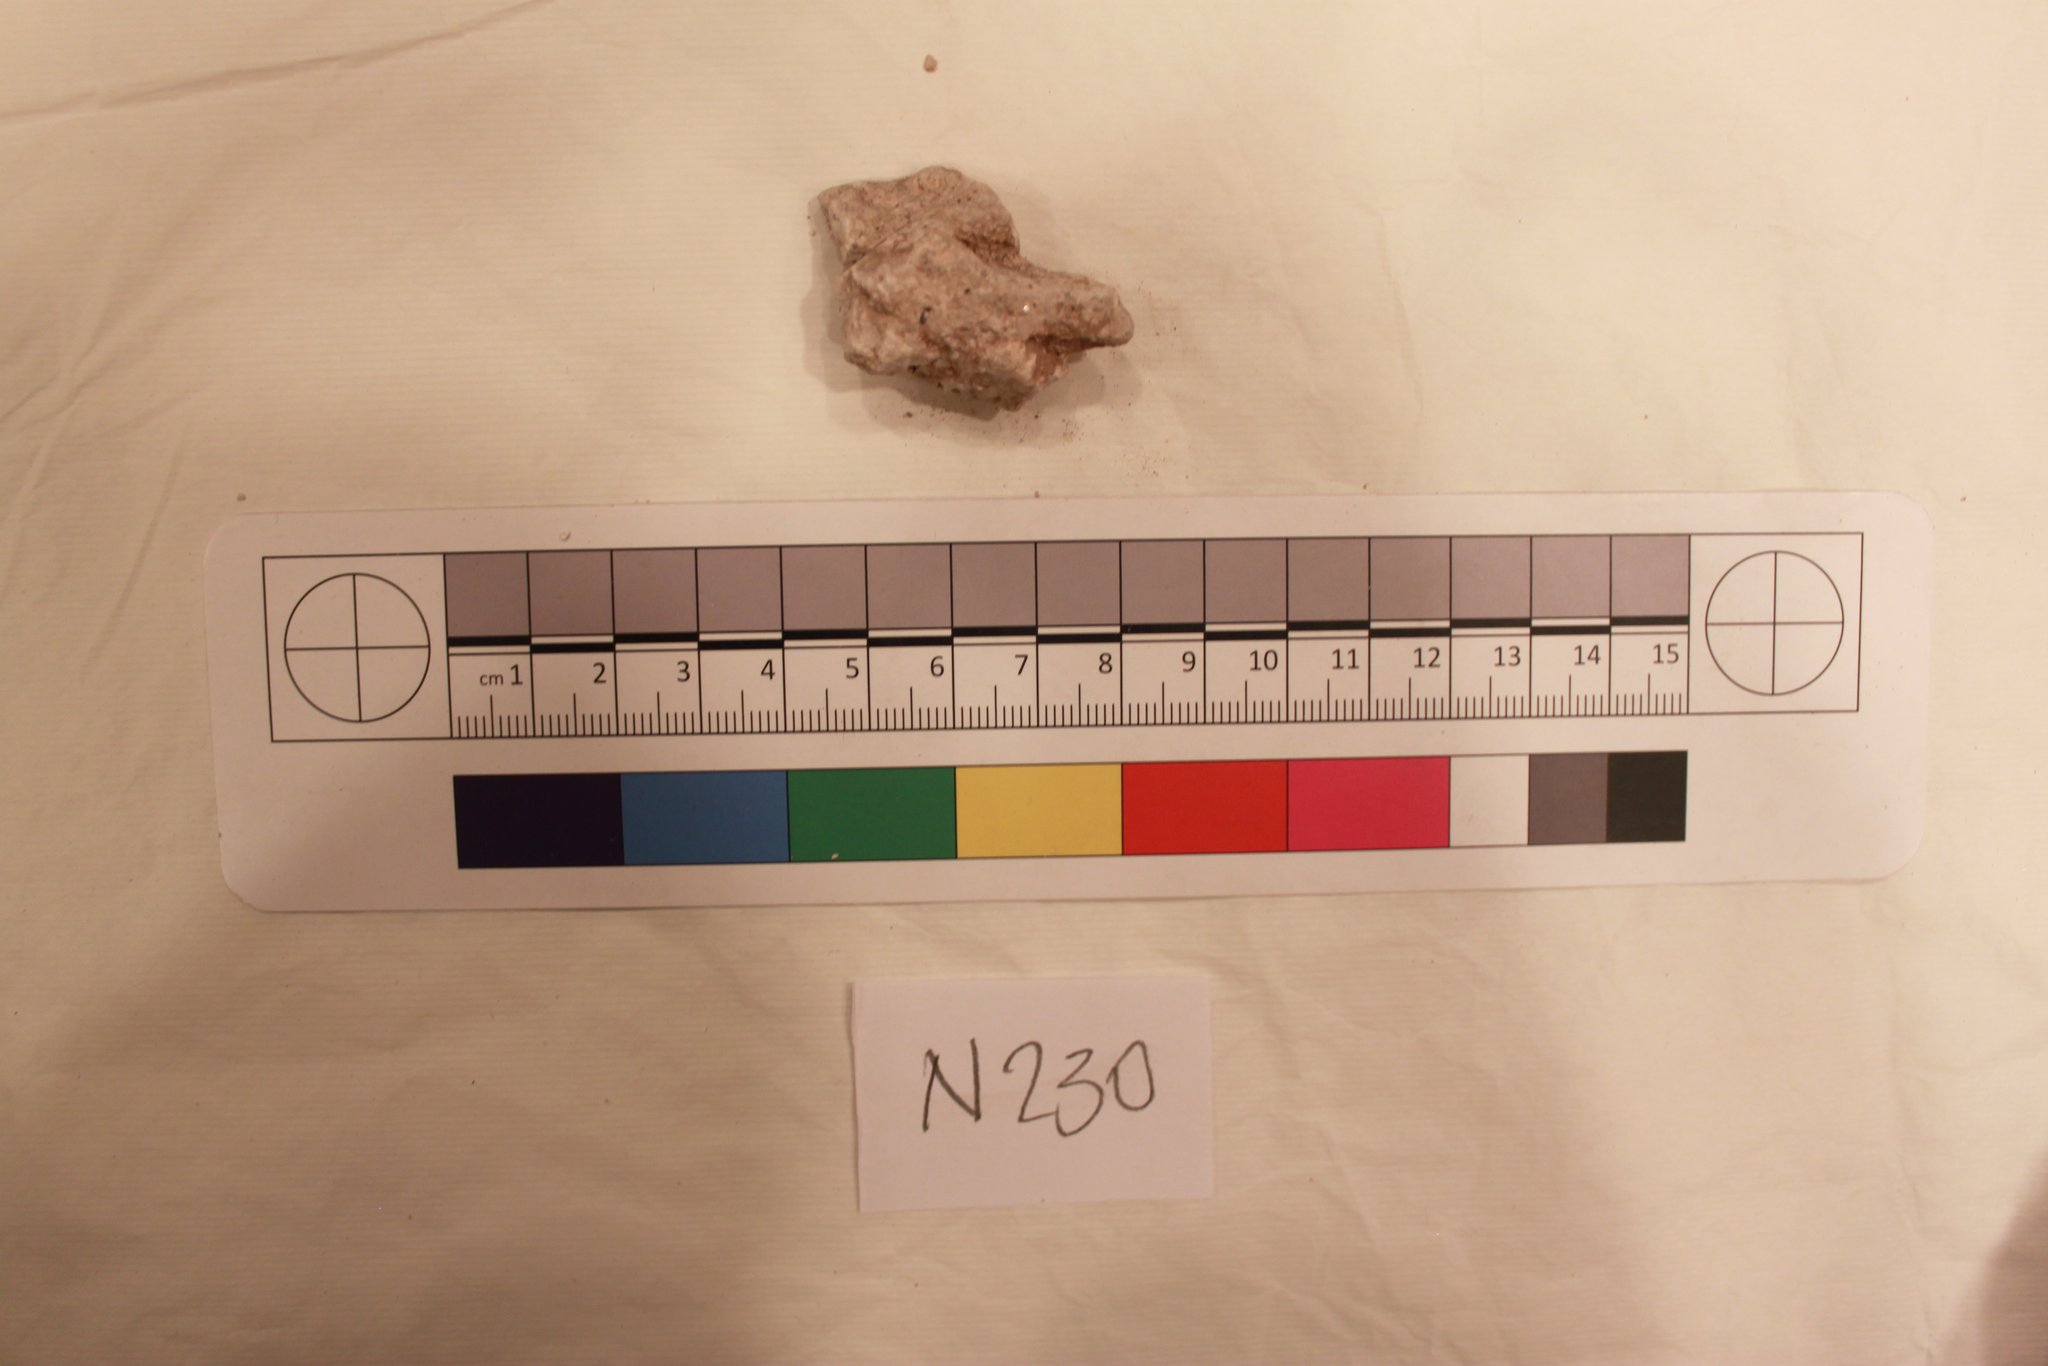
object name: fragment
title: Stucco Fragment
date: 701-1200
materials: plaster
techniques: carving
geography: iran